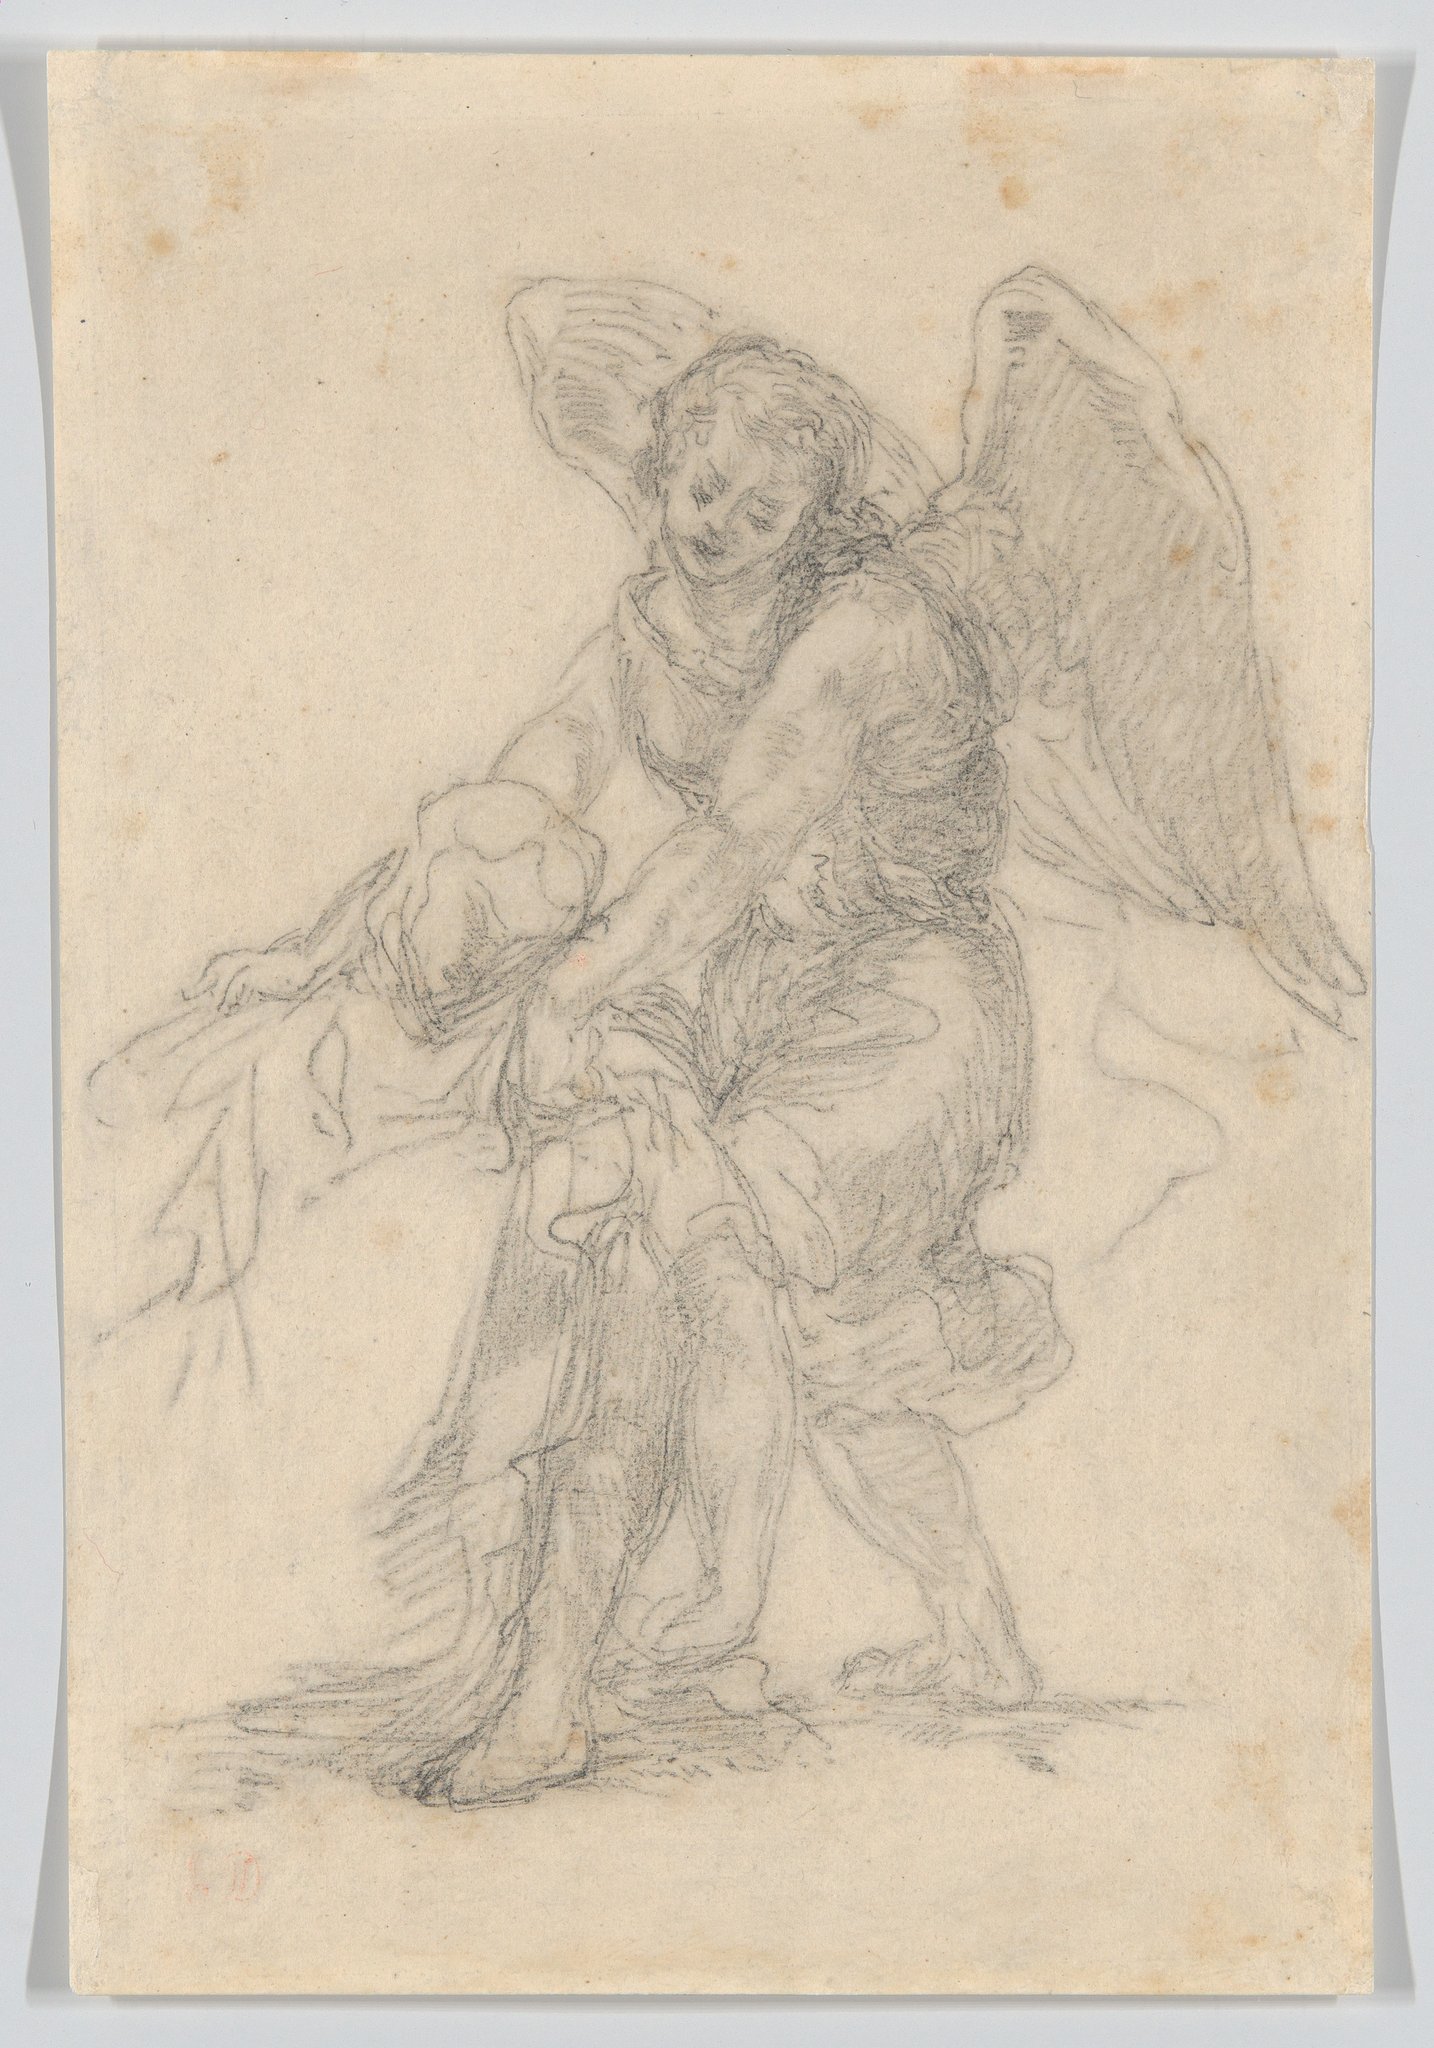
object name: drawing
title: Angel Holding the Dead Christ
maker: eugène delacroix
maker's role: artist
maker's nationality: french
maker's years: 1798-1863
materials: graphite